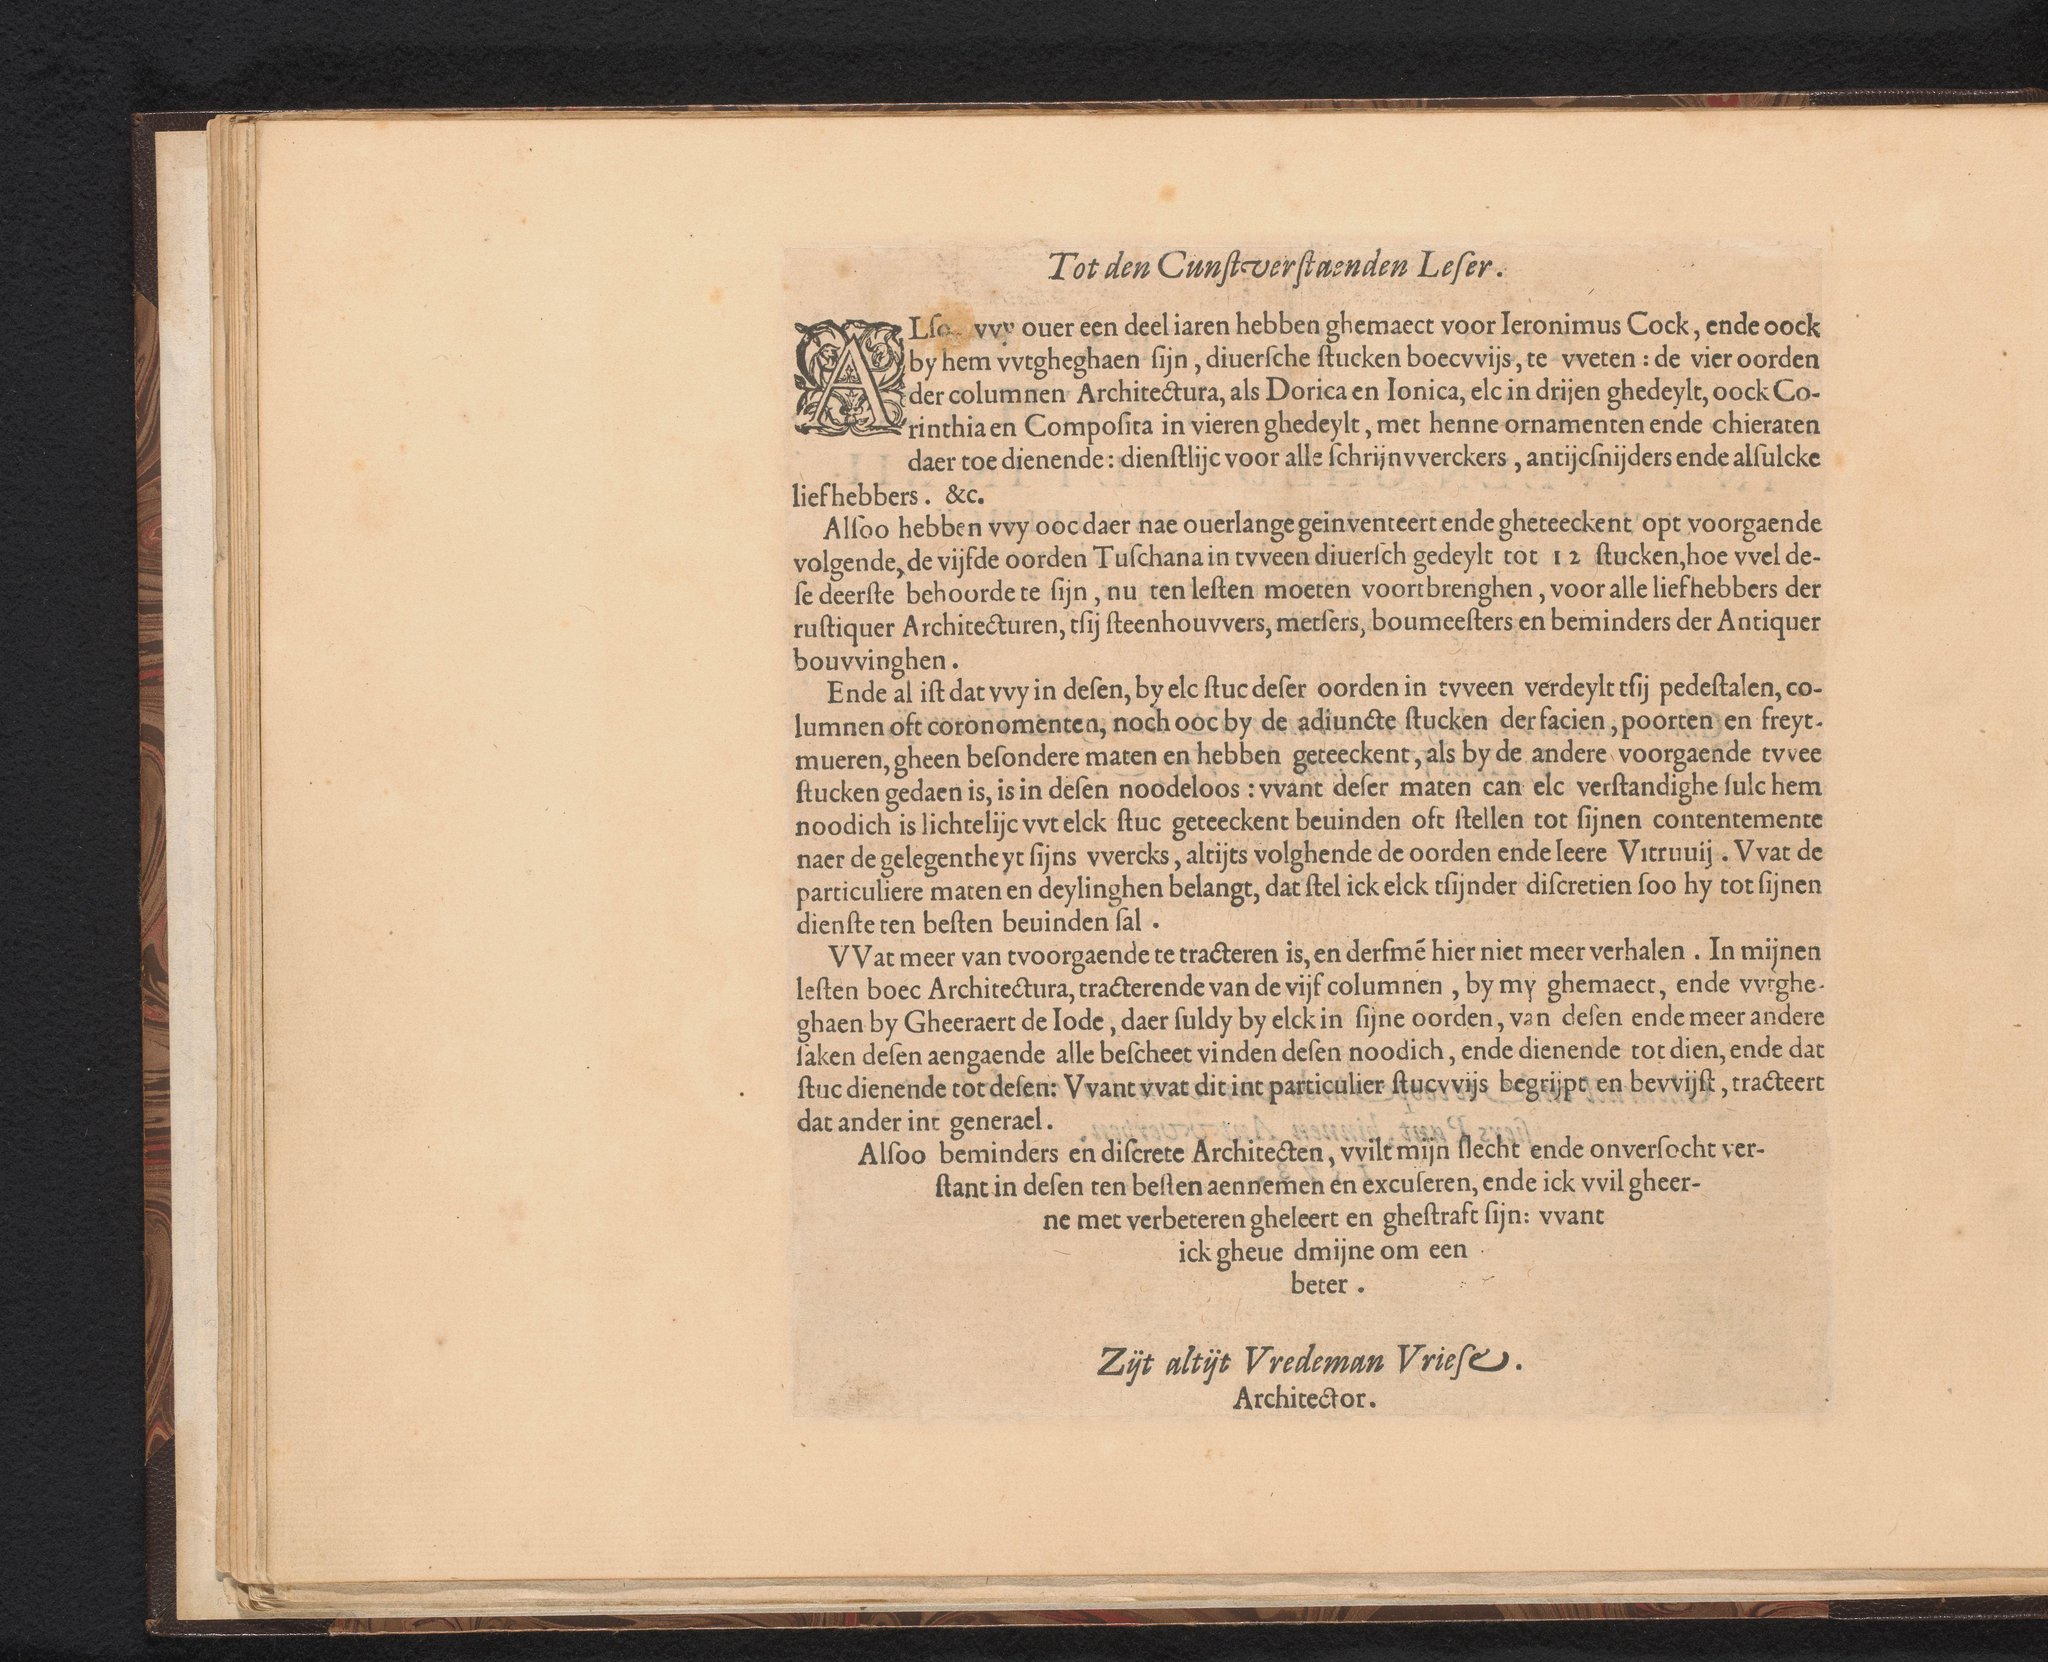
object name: text sheet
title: Architectura de Oorden Tusschana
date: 1578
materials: paper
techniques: letterpress printing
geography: antwerp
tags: initial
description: Inleiding bij de serie: Architectura de Oorden Tusschana ... De tekst begint met een initiaal A. Het blad maakt deel uit van een album.